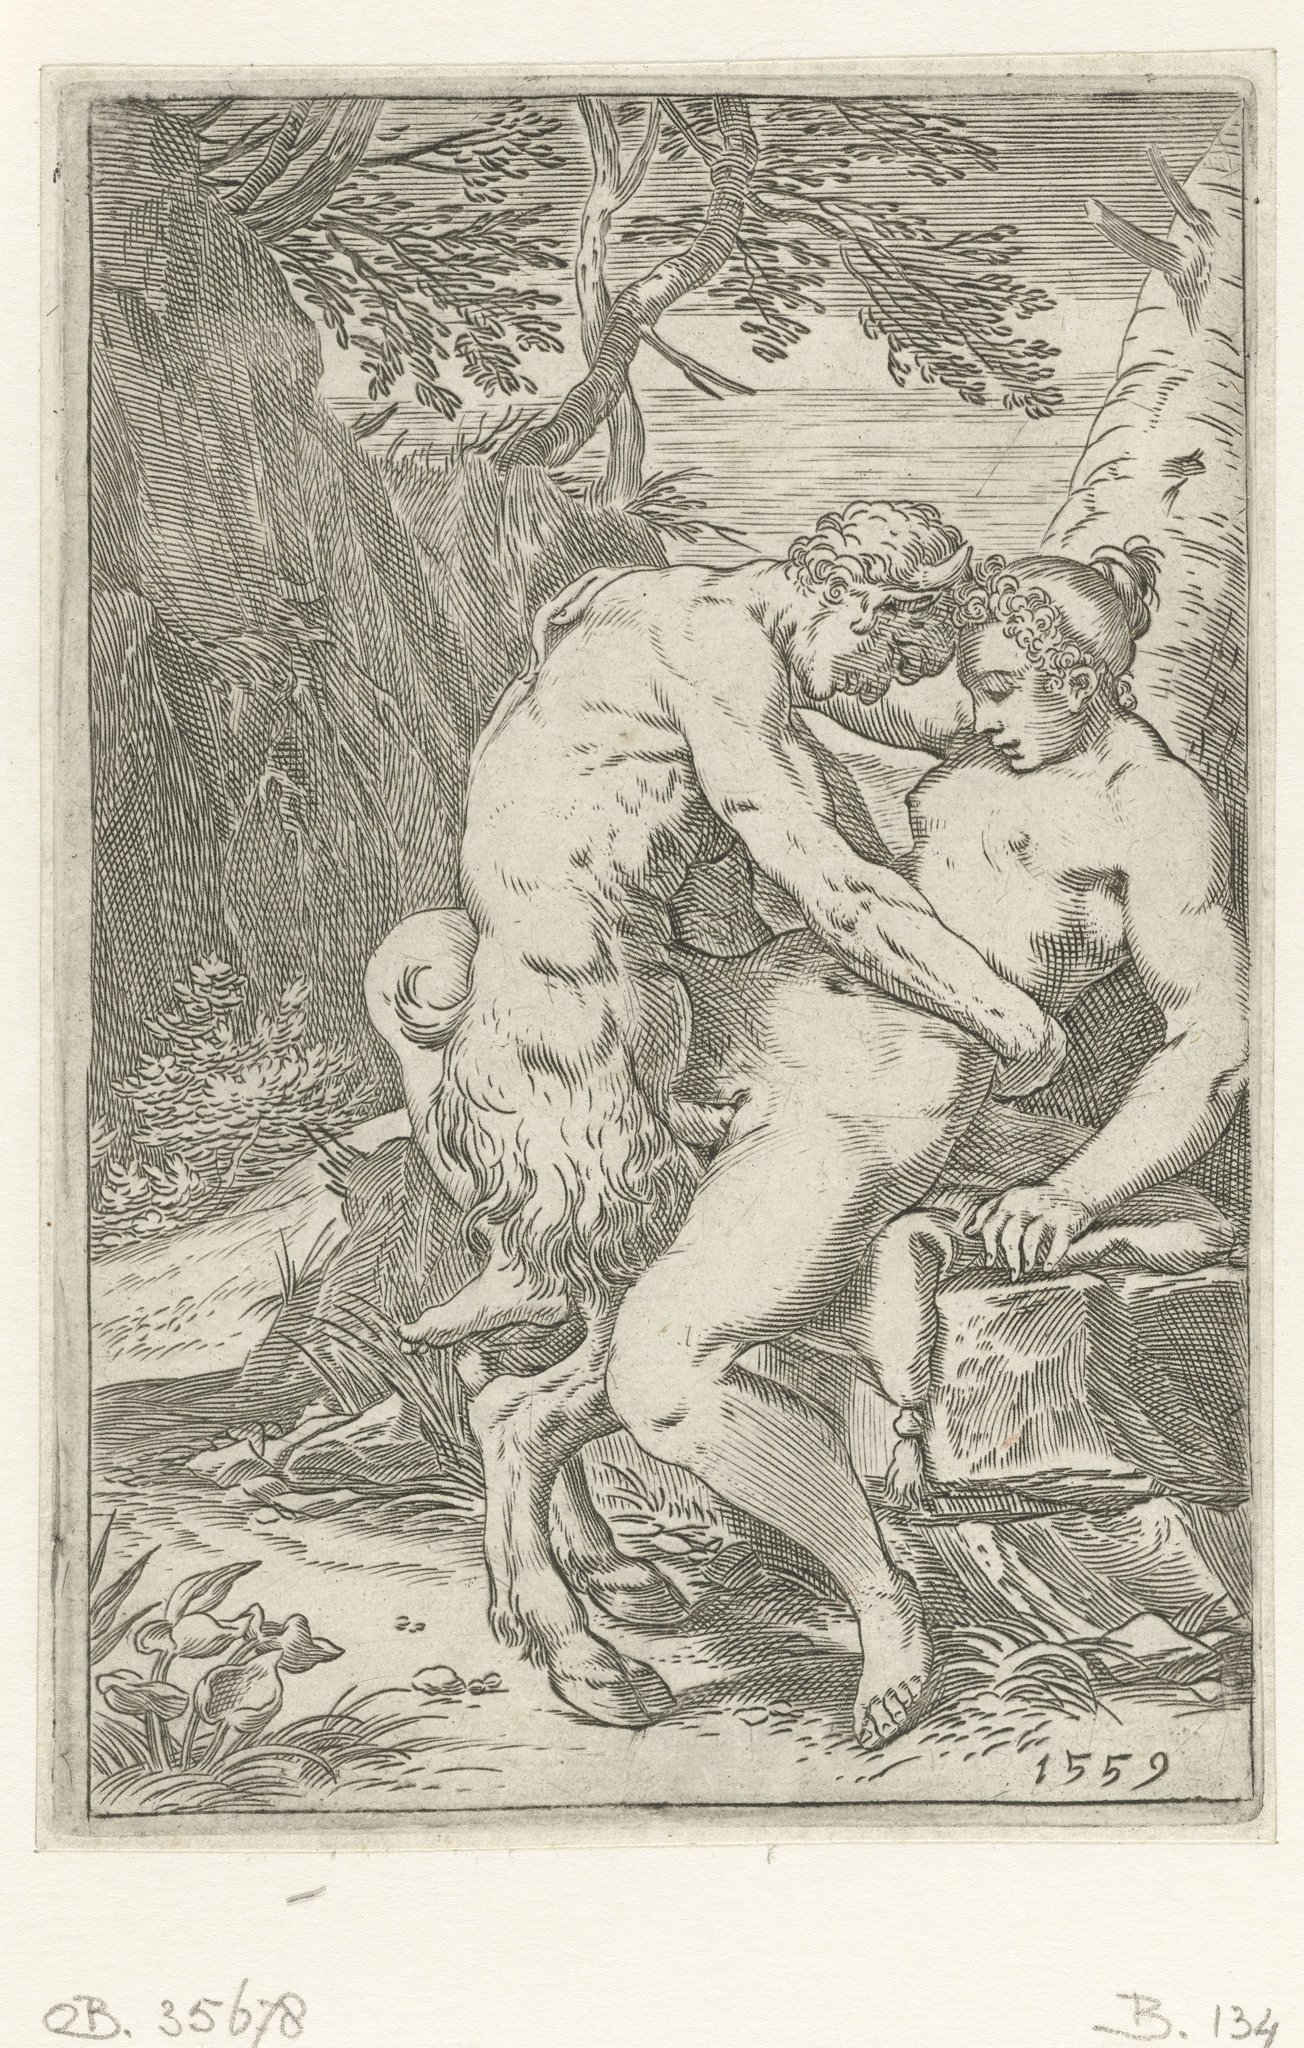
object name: print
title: Sater bedrijft de liefde met een nimf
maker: agostino carracci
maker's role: draughtsman, painter, print maker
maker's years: 1557-1602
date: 1559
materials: paper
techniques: engraving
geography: italy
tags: nymphs (in general); 'ninfe in commune' (ripa), satyr(s) (in general), satyr(s) pursuing nymph(s), coitus, cohabiting, sexual intercourse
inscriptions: collector's mark: Lugt 2228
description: Een erotische scène met een sater die de liefde bedrijft met een nimf tegen een boom.